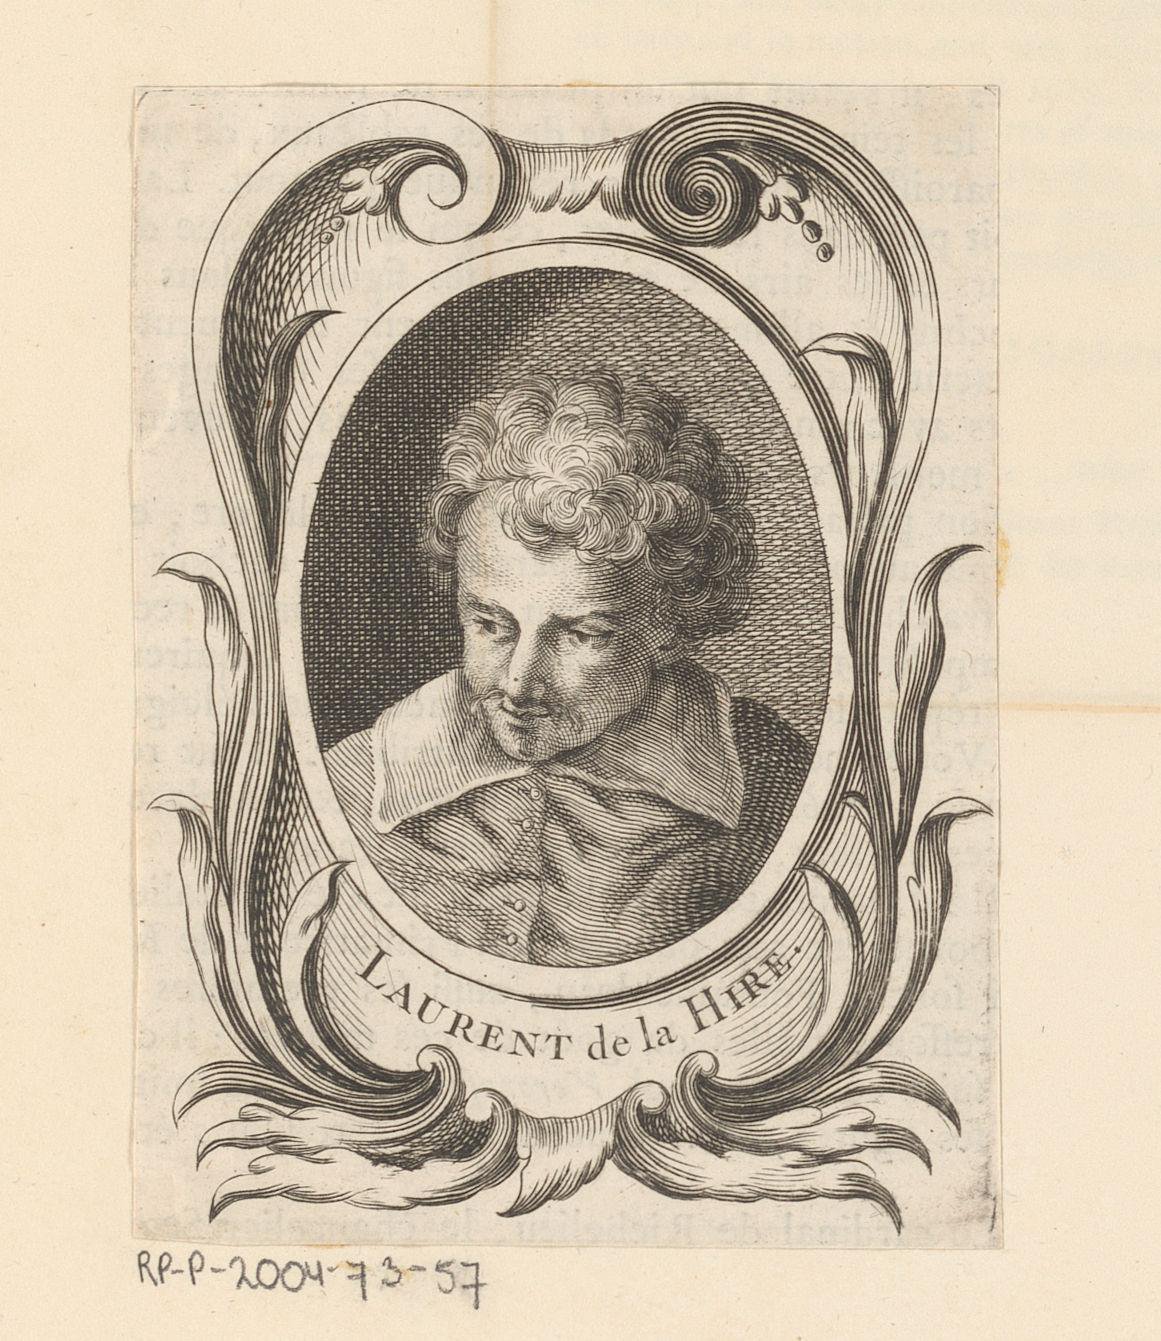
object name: print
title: Portret van Laurent de la Hire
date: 1745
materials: paper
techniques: engraving, letterpress printing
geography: paris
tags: paris, painter, print maker, draughtsman, laurent de la hire, historical persons, portrait, self-portrait of painter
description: Prent uit: Dézallier d'Argenville, Antoine Joseph. Abrégé de la vie des plus fameux peintres. 4 dln. Parijs: De Bure l'aîné, 1745, dl. 2, p. 271. De samensteller heeft deze prent in het album geplakt als illustratie bij: Pilkington, Matthew en Johann Heinrich Füssli. A dictionary of painters, from the revival of the art to the present period. 4 dln. Londen: John Crowder, 1805, dl. 2, p. 245.